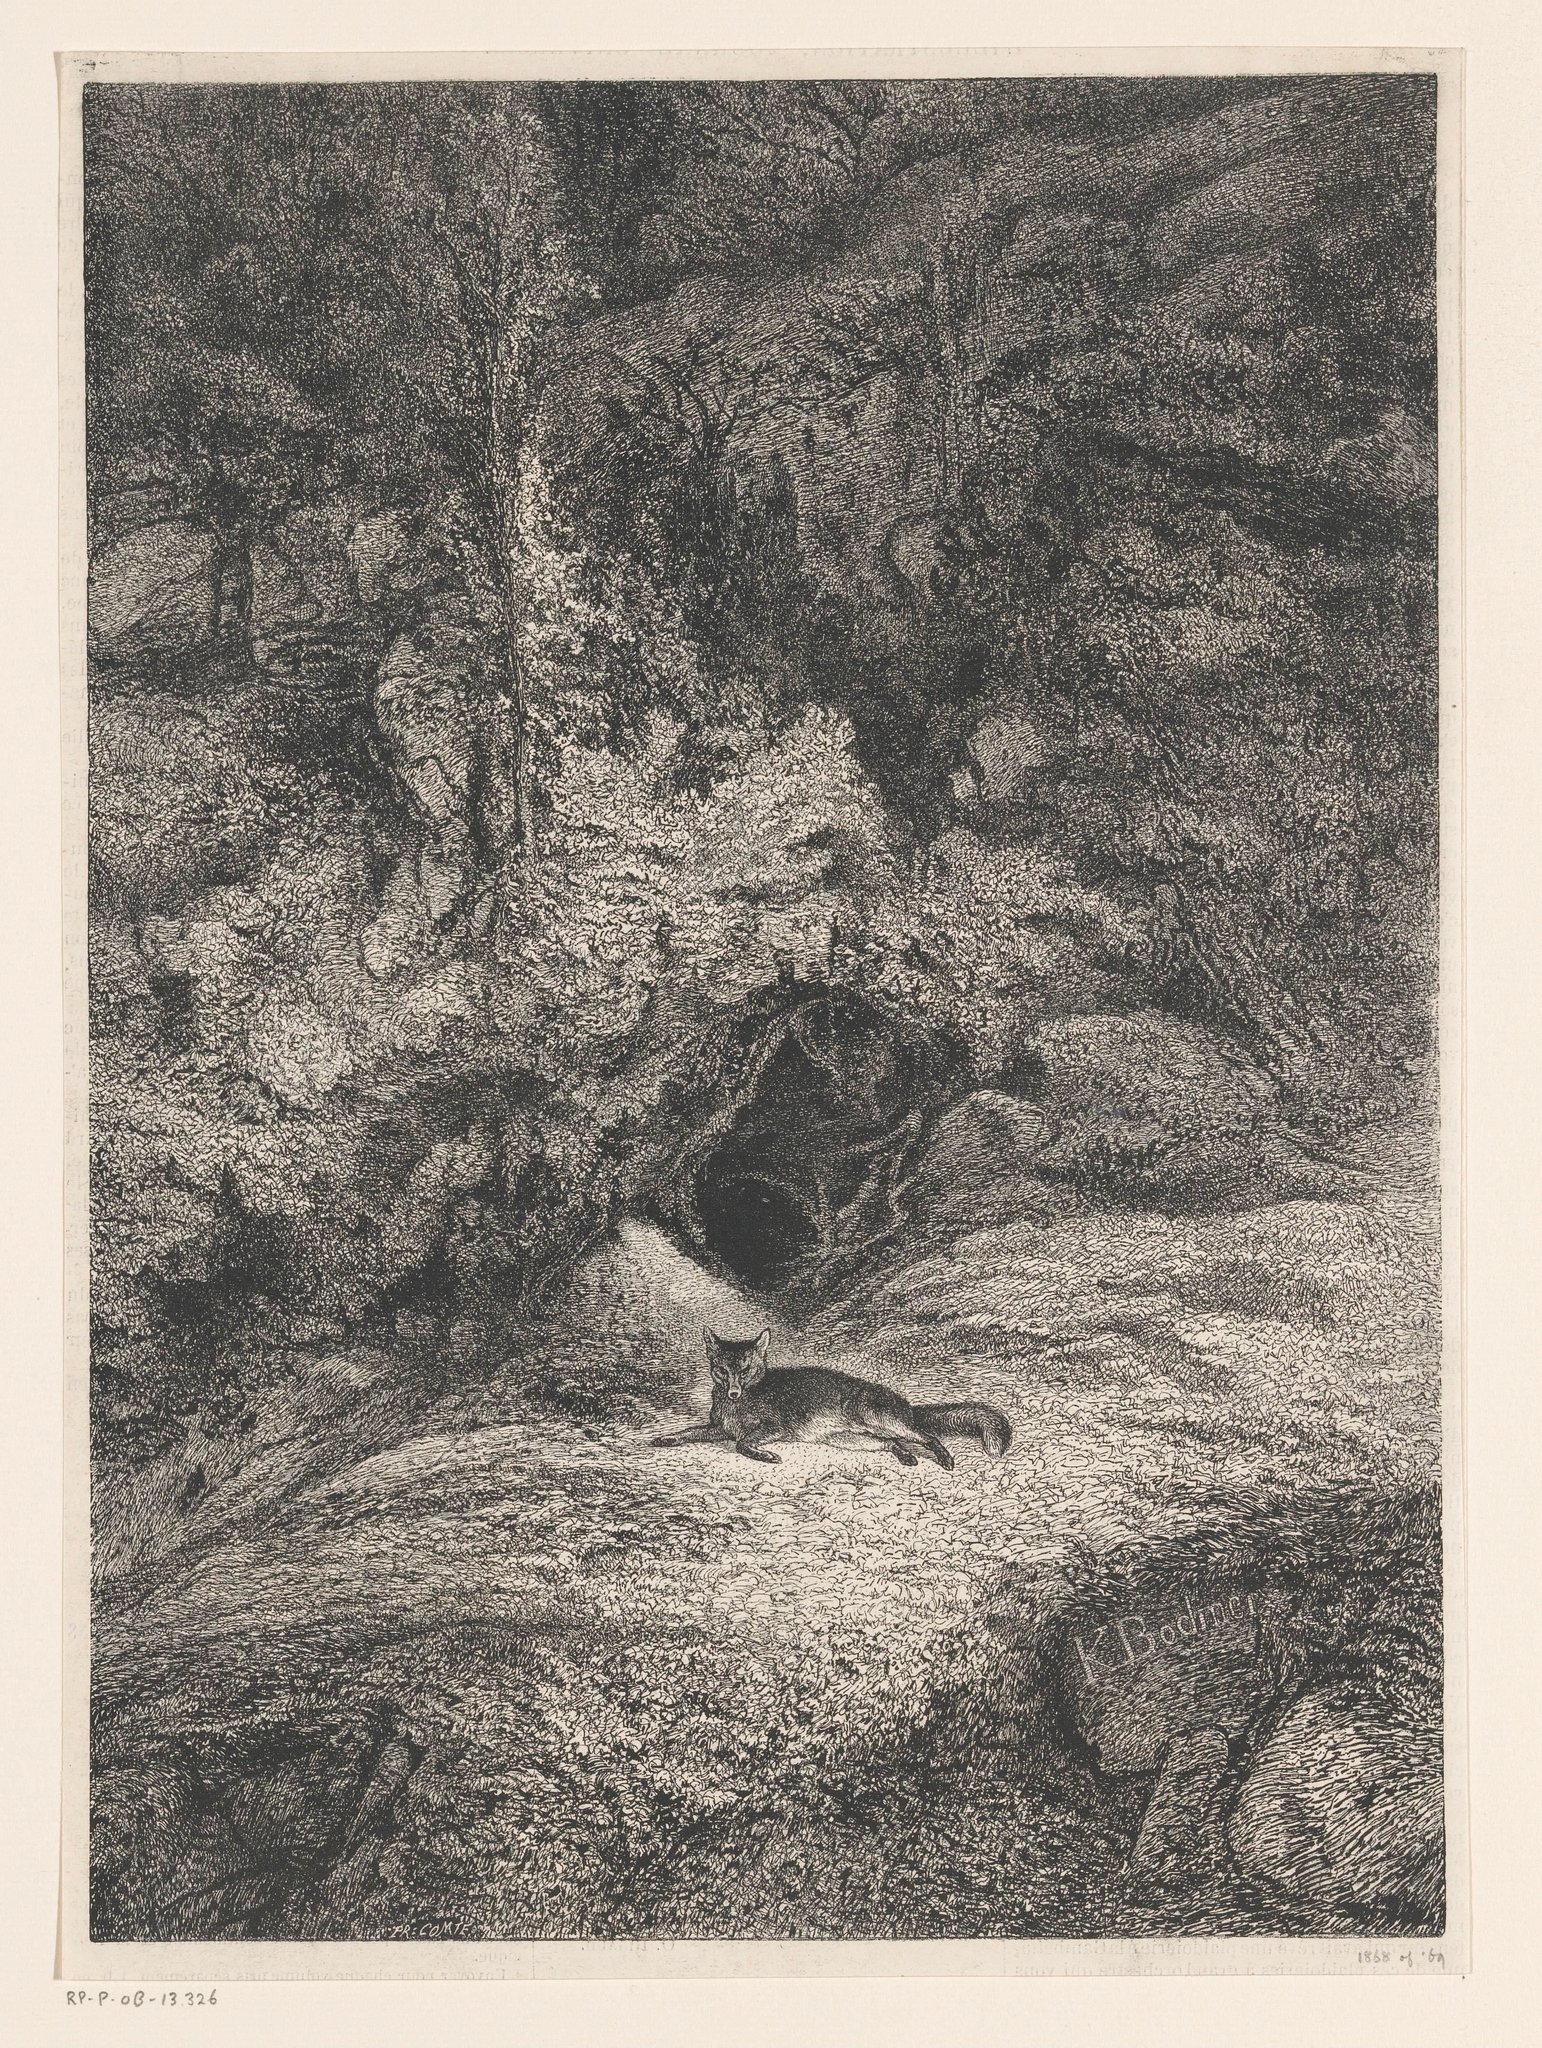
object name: print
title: Twee antieke medaillons met de portretten van Constantijn en Claudia Octavia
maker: franz isaac brun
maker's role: print maker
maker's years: 1535-1620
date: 1559-1596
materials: paper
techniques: engraving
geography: germany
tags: historical persons - bb - woman, historical persons, medal (considered as a piece of sculpture, regardless of its specific function)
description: Deze prent maakt deel uit van een serie met antieke medaillons. Mogelijk zijn deze prenten gebaseerd op de illustraties in houtsnede, gebruikt in 'Promptuarii Iconum Insigniorum', in 1553 door Guillaume Rouillé uitgegeven in Lyon.